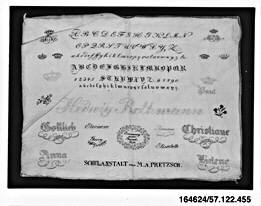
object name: sampler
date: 1858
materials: cotton, linen, metal thread